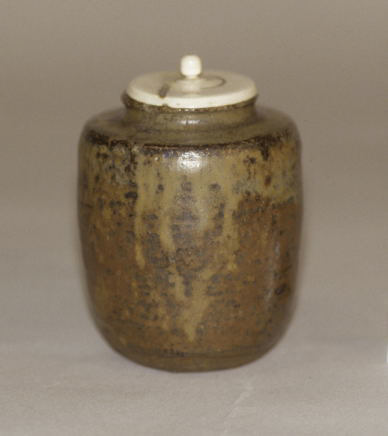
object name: tea jar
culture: japanese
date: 1601-1700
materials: clay, glaze